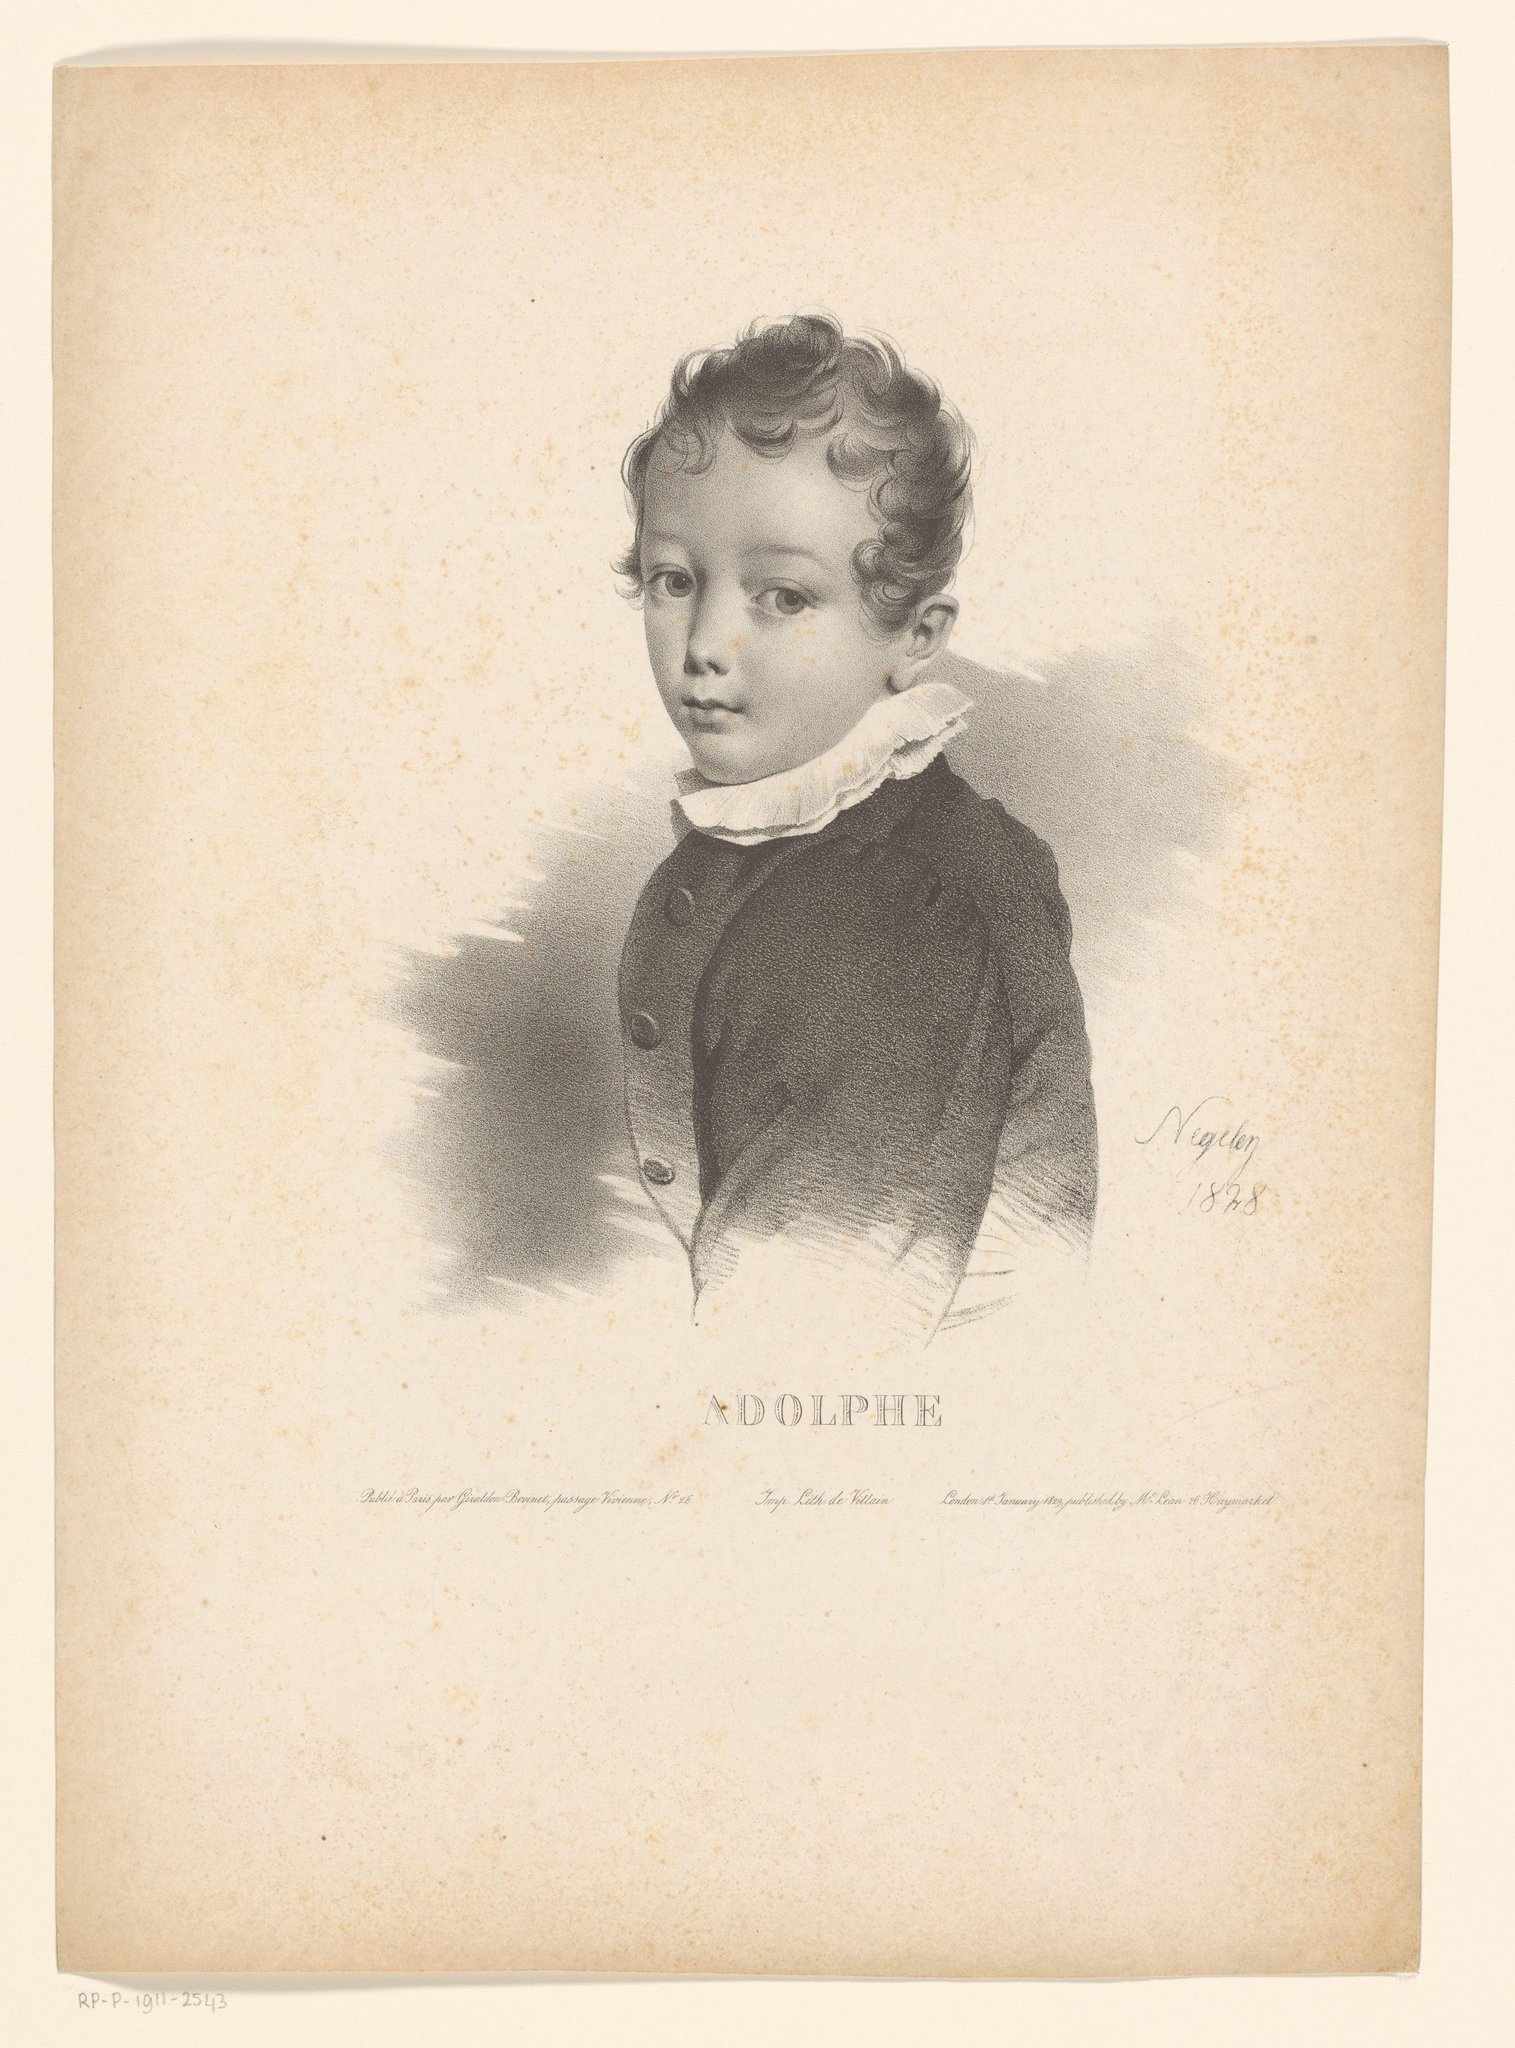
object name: print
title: Adolphe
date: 1828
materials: paper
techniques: lithograph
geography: london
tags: historical persons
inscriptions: collector's mark: Lugt 2228